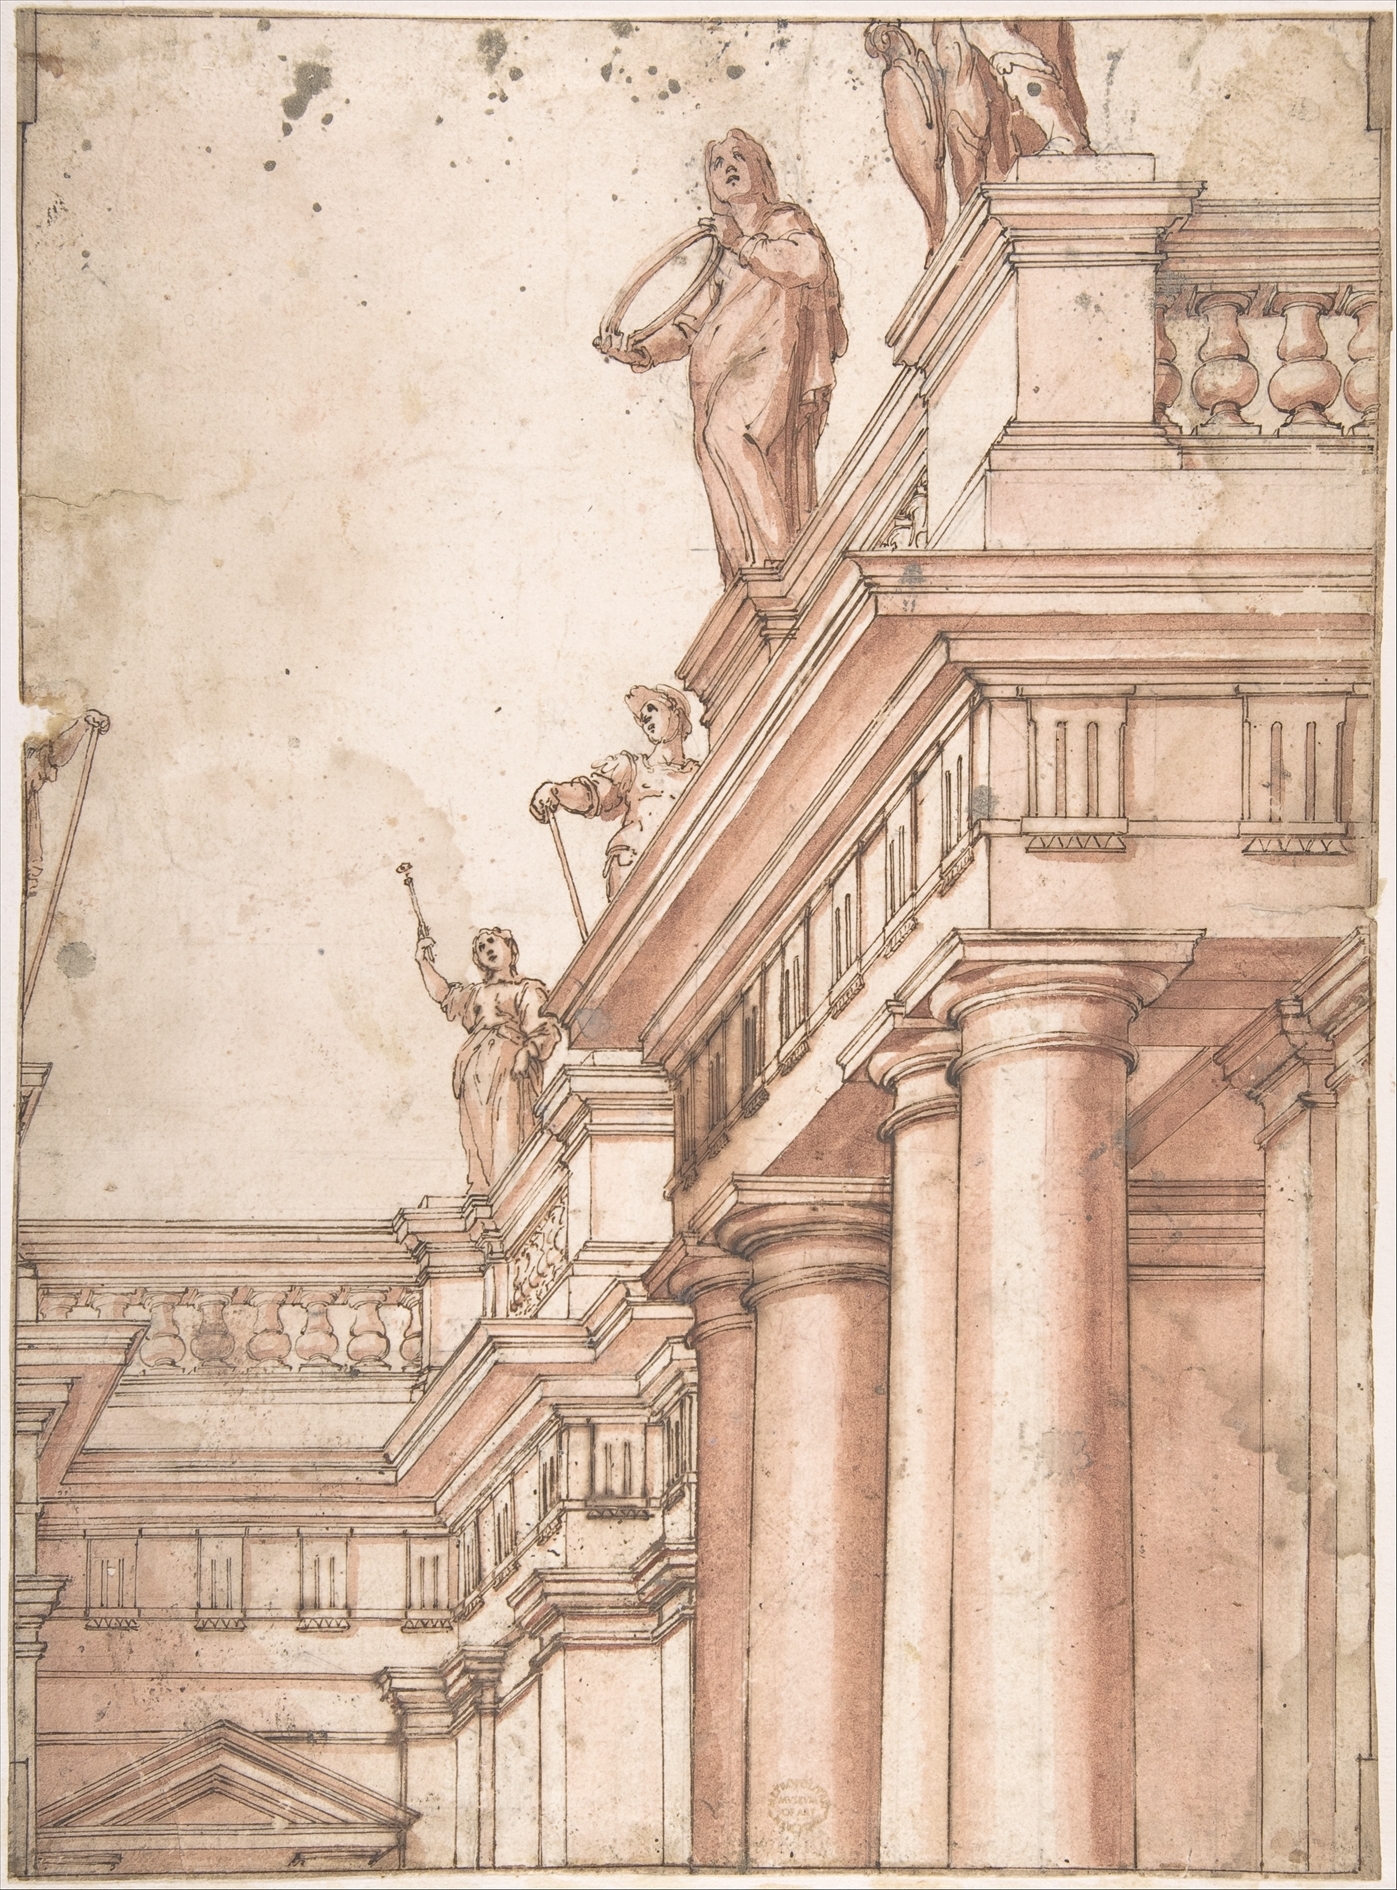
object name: drawing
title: Façade (for Stage Setting)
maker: anonymous, italian, 16th century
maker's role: artist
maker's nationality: italian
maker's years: 1550-1600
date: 1501-1600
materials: ink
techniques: brush, pen, wash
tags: architecture,buildings